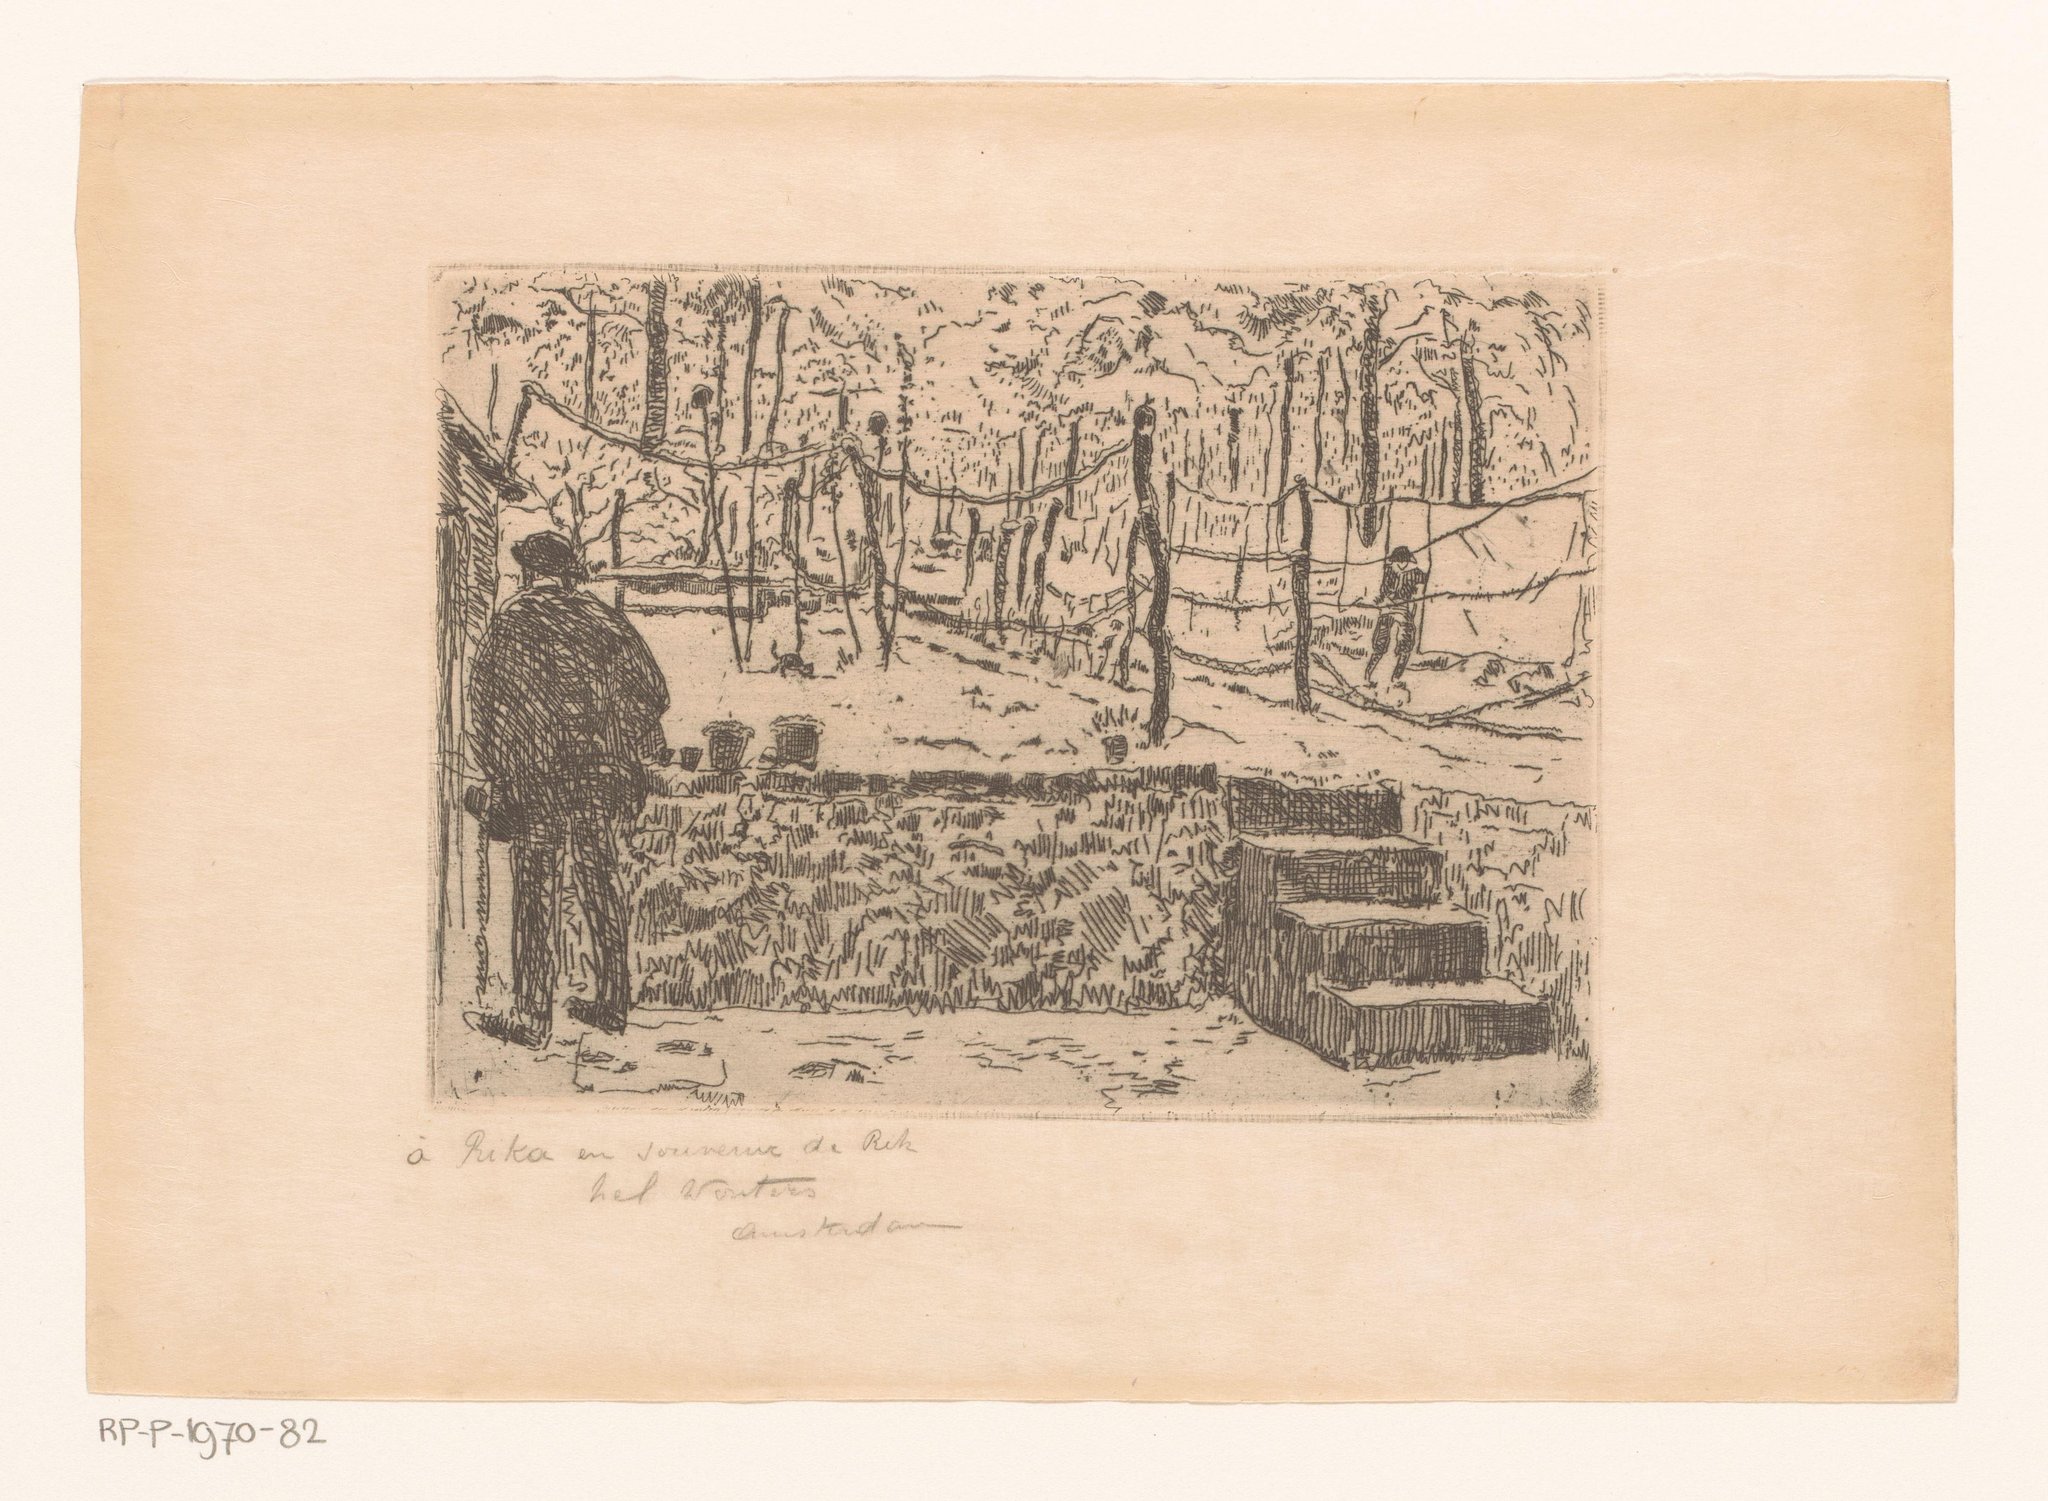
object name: print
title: Besneeuwde tuin te Bosvoorde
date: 1892-1916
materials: paper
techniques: etching, intaglio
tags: garden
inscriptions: collector's mark: Lugt 2228, dedication: ‘à Rika en souvenir de Rik/ Nel Wouters/ Amsterdam’